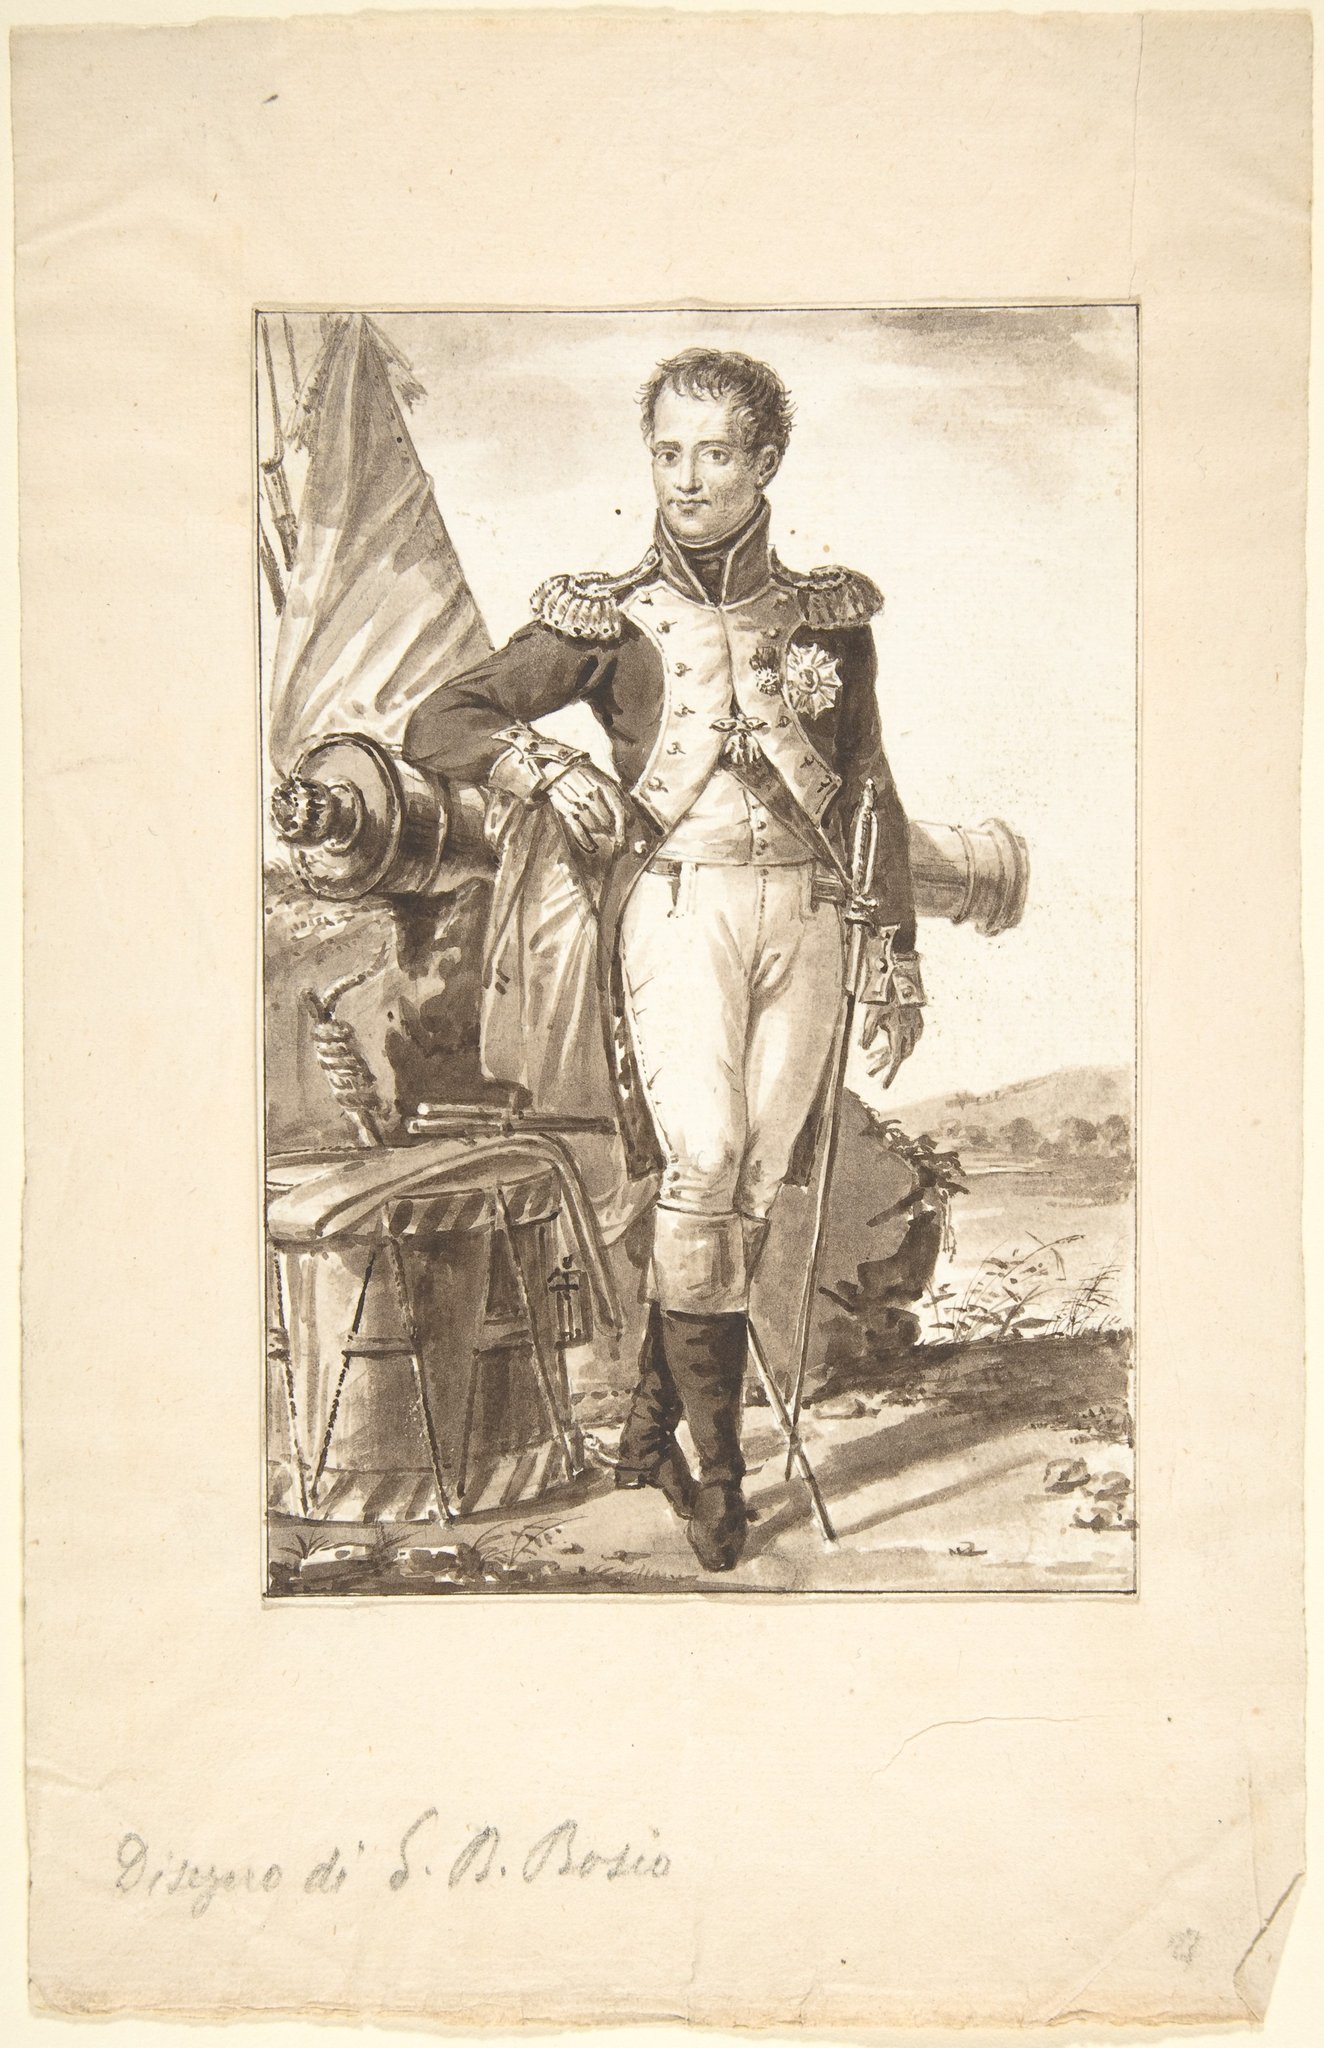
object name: drawing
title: Portrait of Joseph Bonaparte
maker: jean-baptiste-françois bosio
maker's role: artist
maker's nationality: french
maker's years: 1764-1827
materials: graphite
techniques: brush, wash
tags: cannons,men,portraits,drums